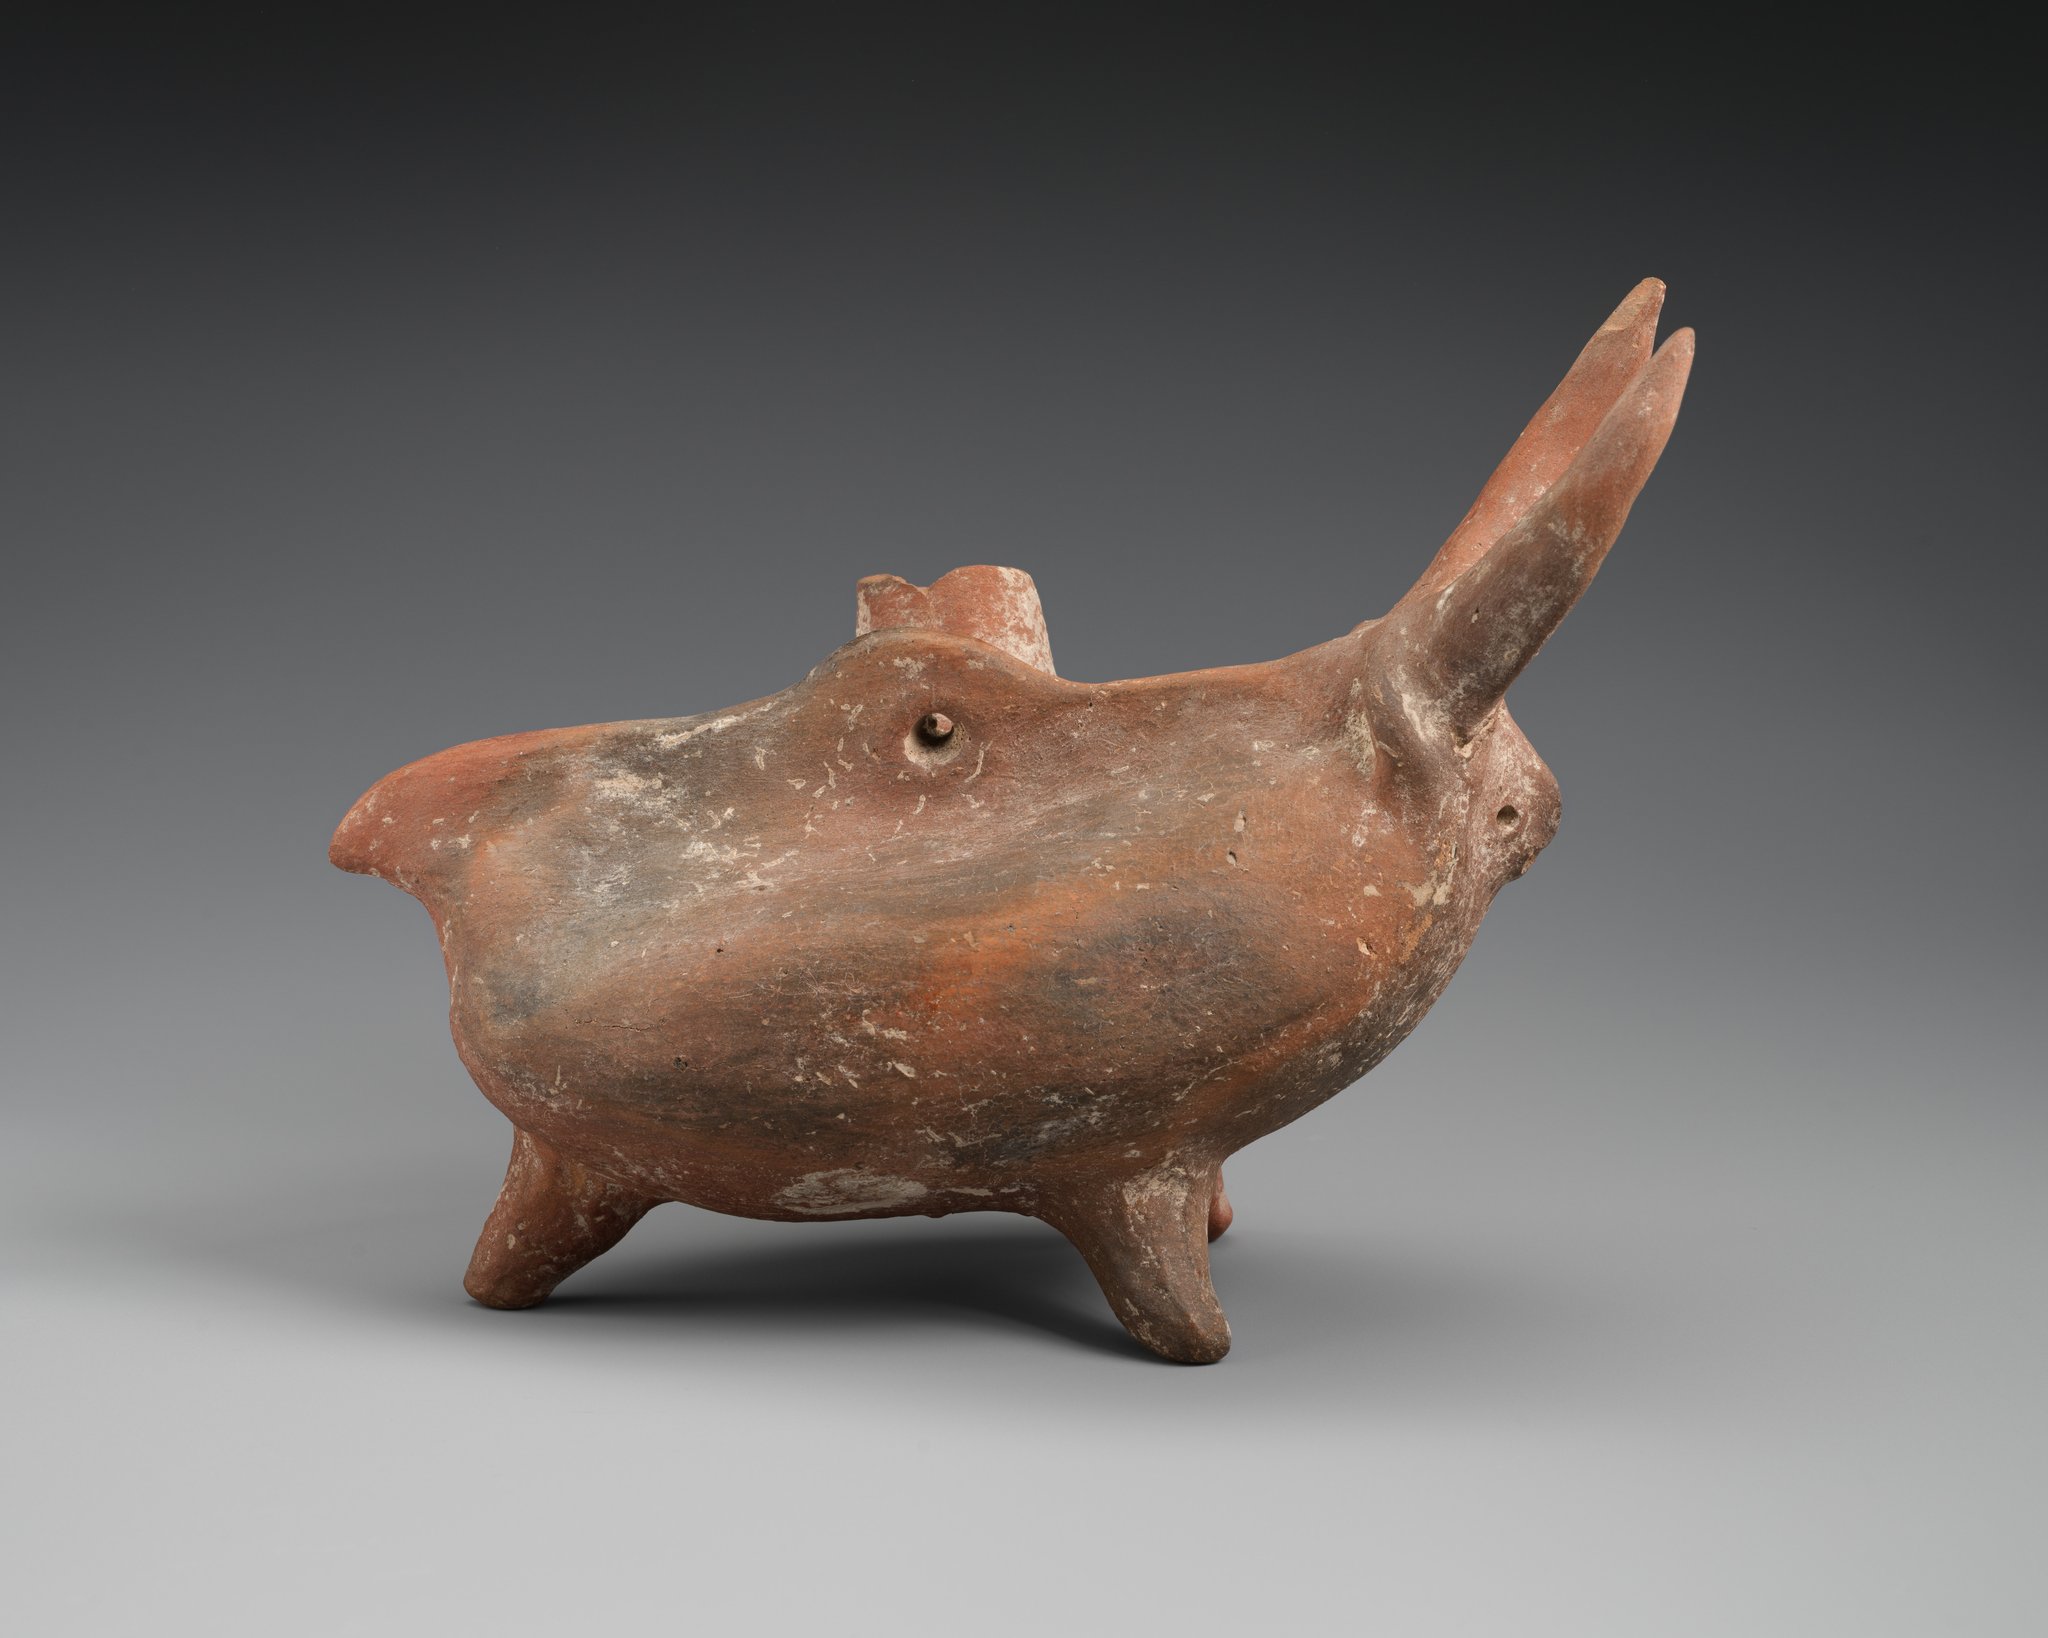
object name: askos in the form of an animal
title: Terracotta askos (vessel) in the form of an animal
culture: cypriot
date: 2500-1900 BCE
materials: terracotta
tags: animals